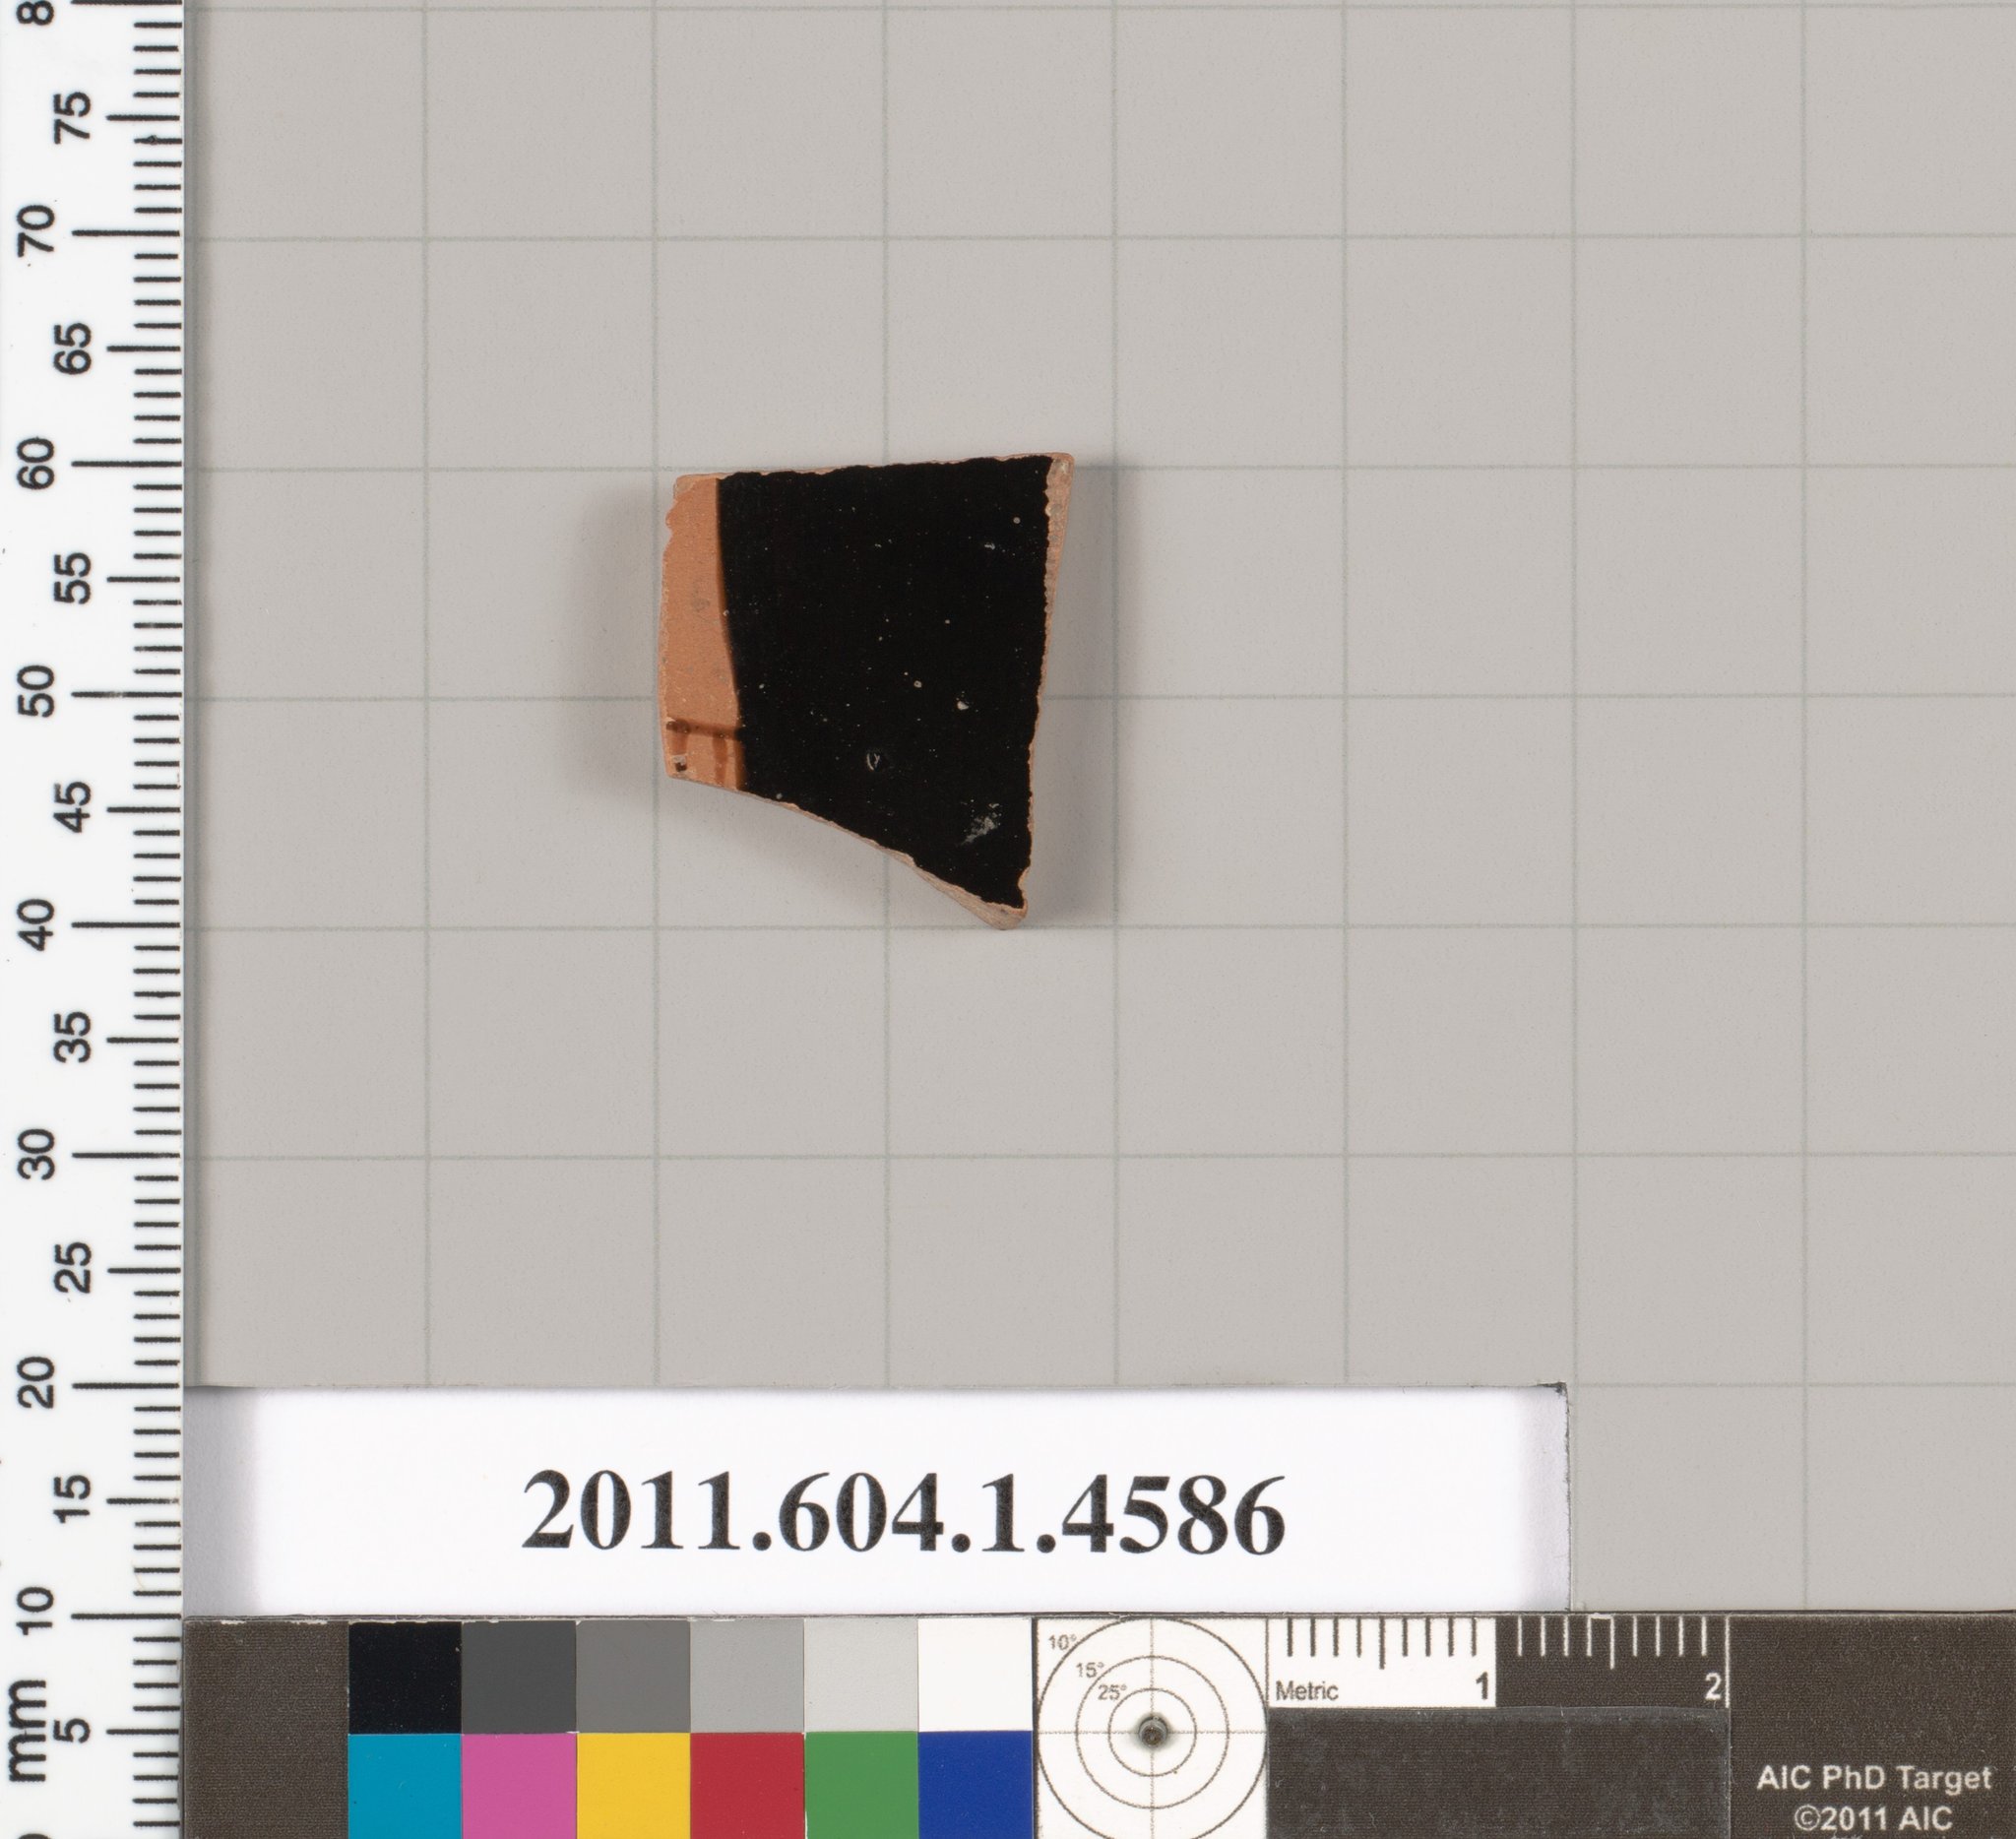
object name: kylix fragment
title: Terracotta fragment of a kylix (drinking cup)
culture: greek, attic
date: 475-451 BCE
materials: terracotta